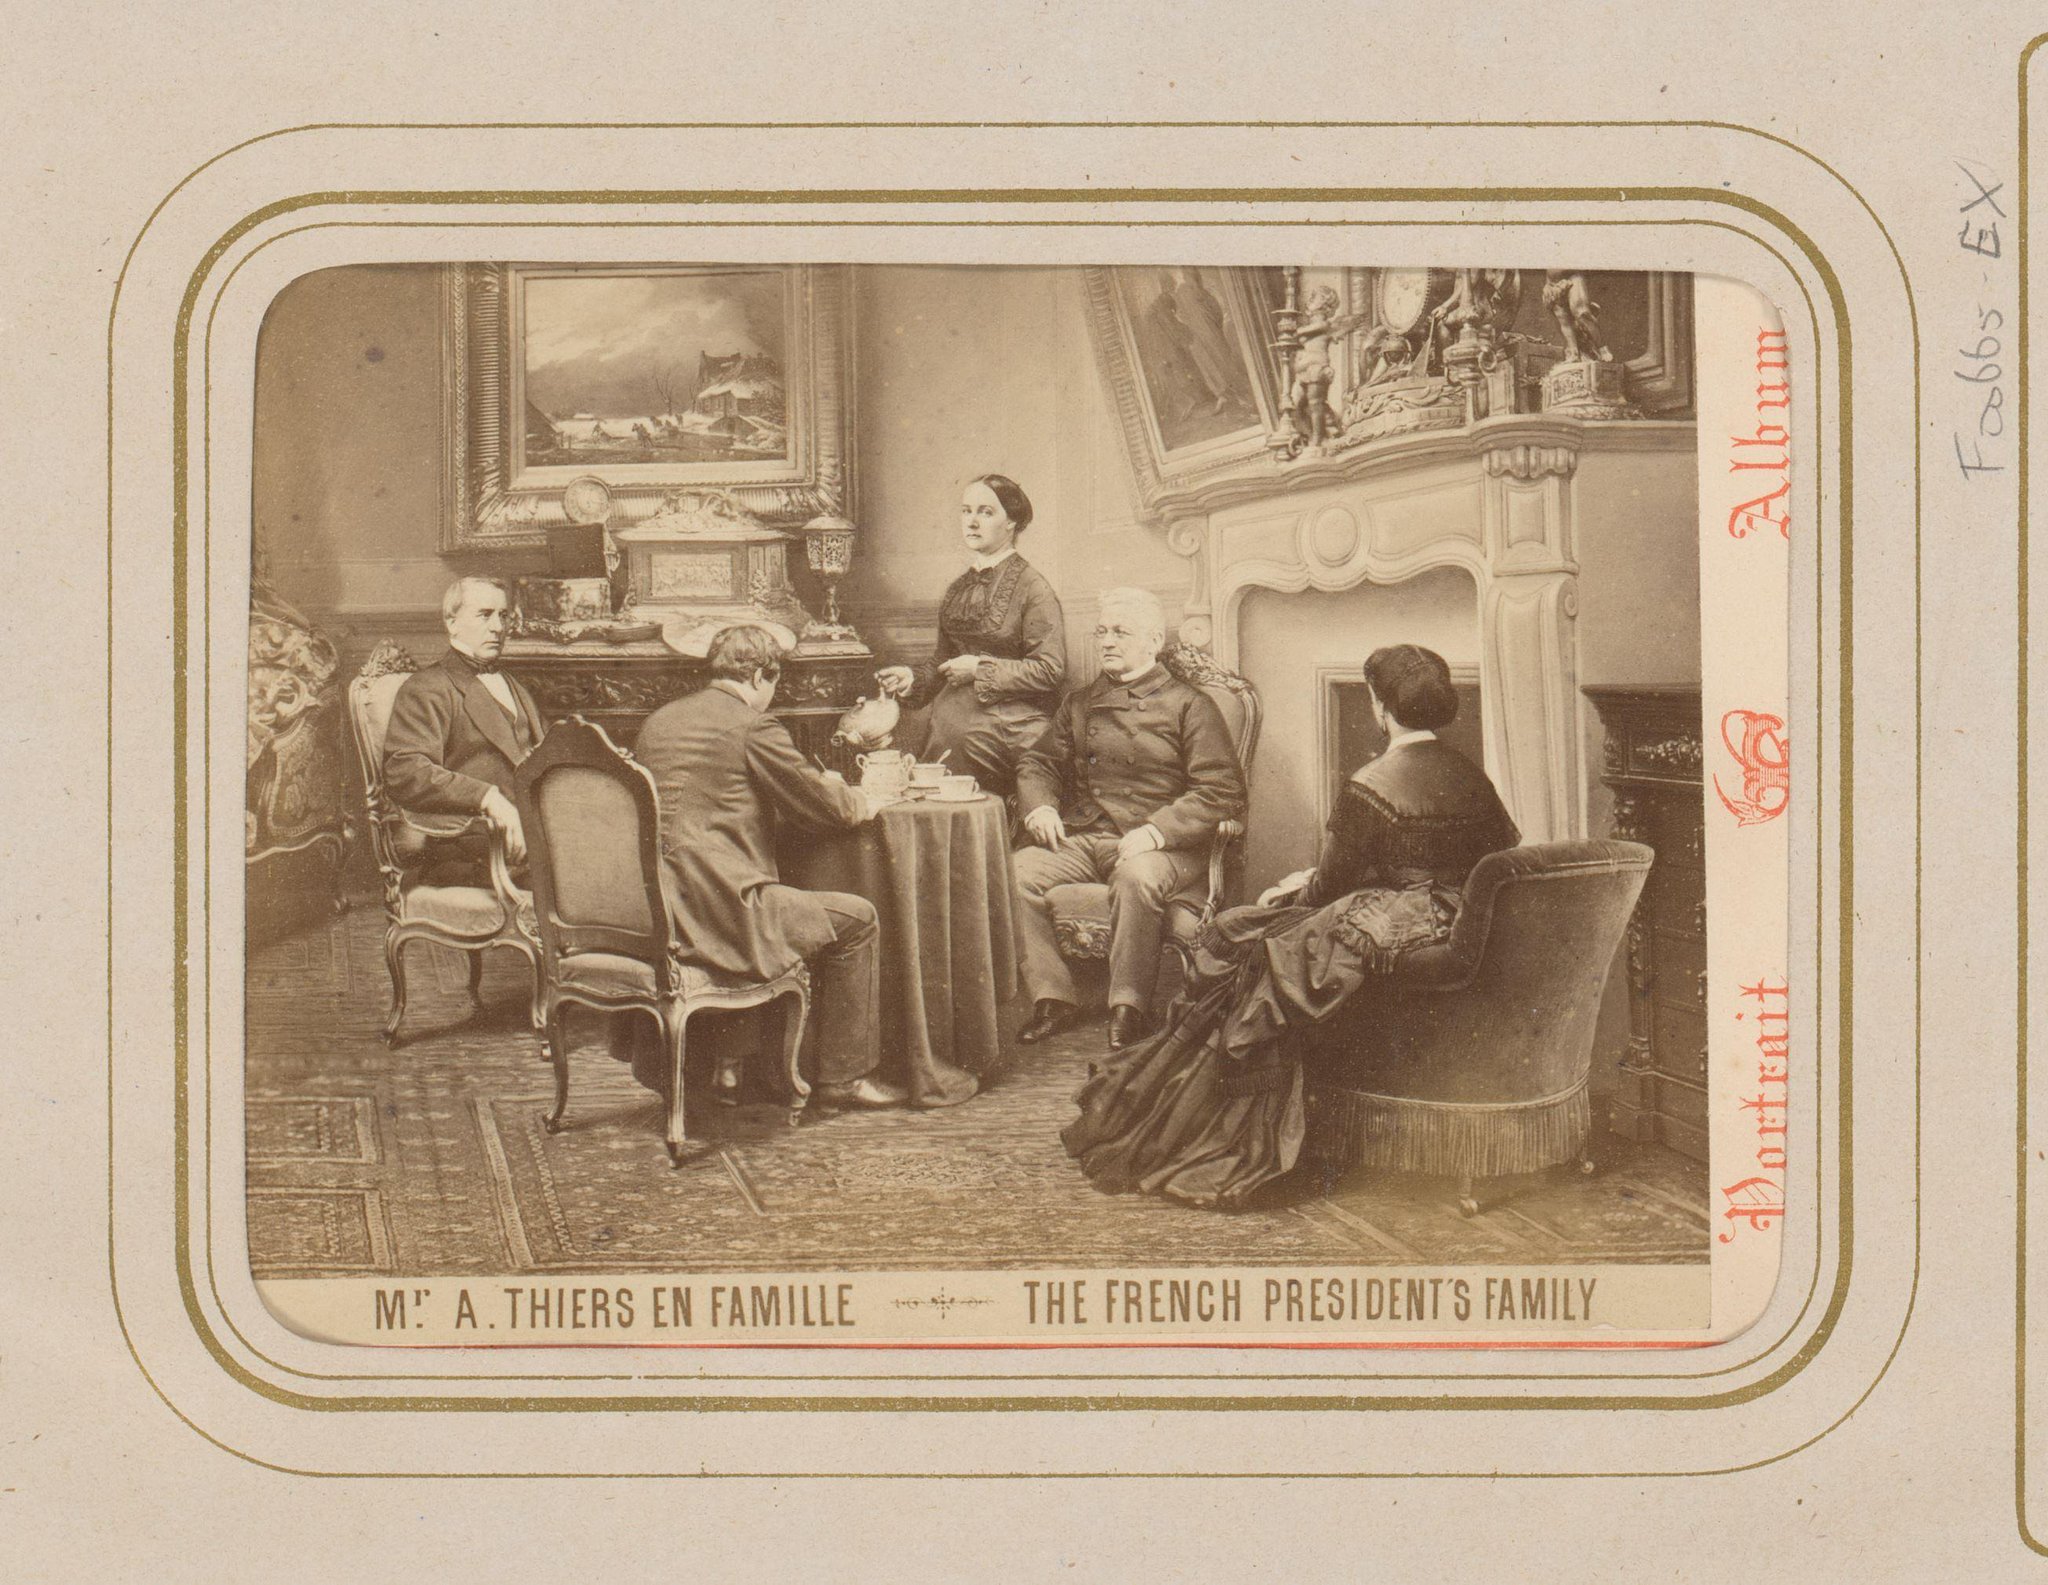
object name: photograph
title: Groepsportret van Louis-Adolphe Thiers en zijn famille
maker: emmanuel louis flamant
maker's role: fotograaf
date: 1855-1877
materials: cardboard, photographic support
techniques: albumen print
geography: paris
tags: marseille, politician, interior of the house, anonymous historical persons portrayed in a group, in a group-portrait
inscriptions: inscription: ‘Mr. A. Thiers en famille/ The French president's family’